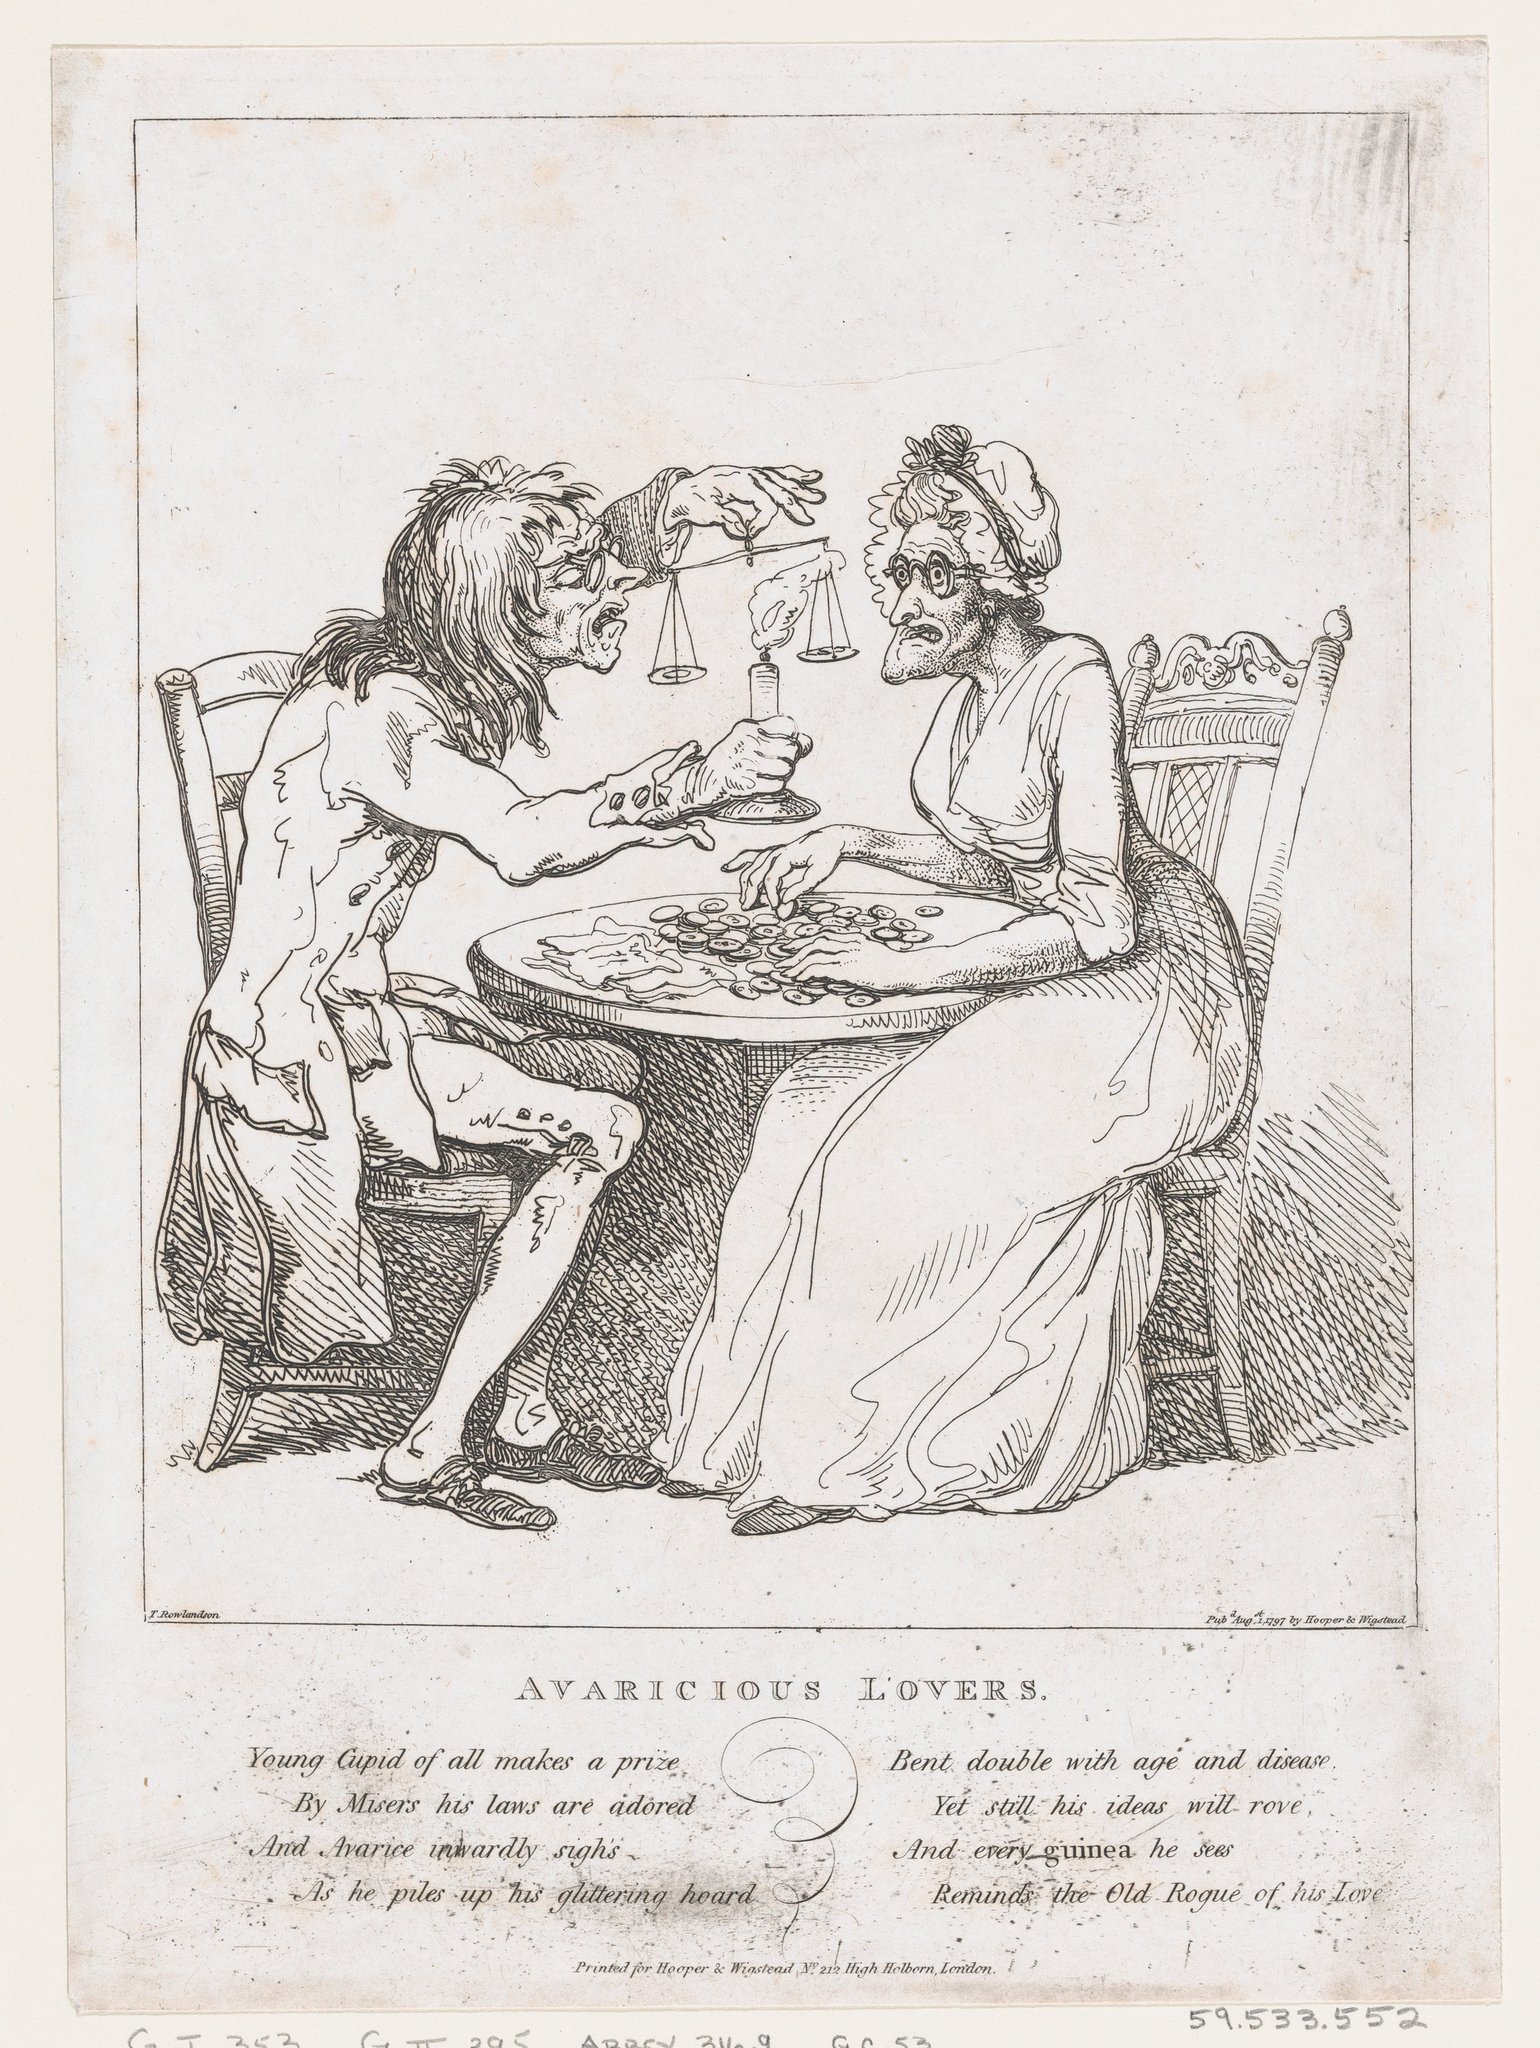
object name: print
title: Avaricious Lovers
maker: thomas rowlandson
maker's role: artist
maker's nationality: british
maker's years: 1757-1827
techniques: etching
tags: satire,men,lovers,women,money